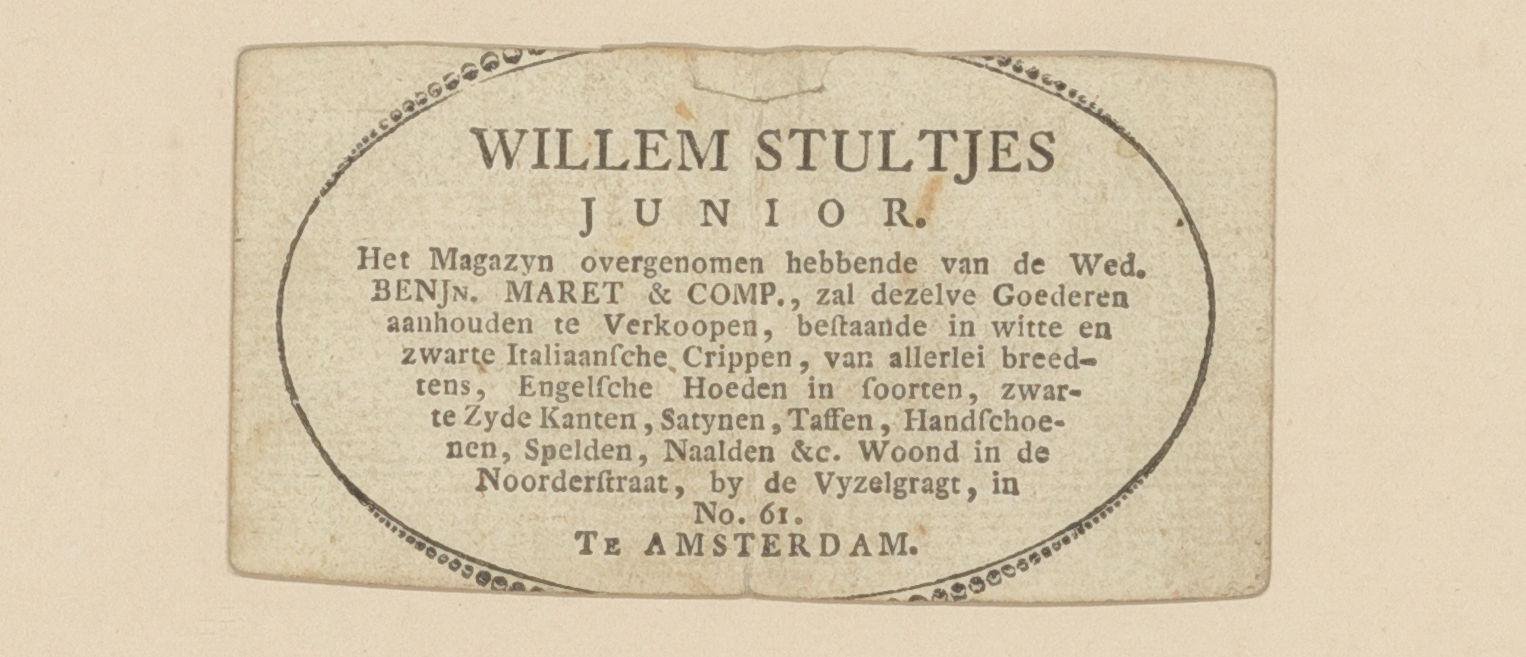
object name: text sheet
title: Handelsetiket van Willem Stultjes junior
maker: Anonymous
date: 1780-1815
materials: paper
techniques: letterpress printing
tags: merchant, salesman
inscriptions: collector's mark: Lugt 1641, stamp, stamp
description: Handelsetiket van Willem Stultjes junior, na de overname van de winkel van de weduwe Maret & Compagnie. Hij blijft dezelfde goederen verkopen, met onder andere hoeden, kant, satijn, handschoenen, spelden en naalden. De winkel bevindt zich op de Noorderstraat te Amsterdam. Onderwerpsrubrieken binnen de Atlas Zeden en Gewoonten: Handel, nijverheid en verkeer, Koophandel, Veilingen, Makelaardij en Verzekeringswezen, Oude adreskaarten van winkels en fabrieken, reclame.